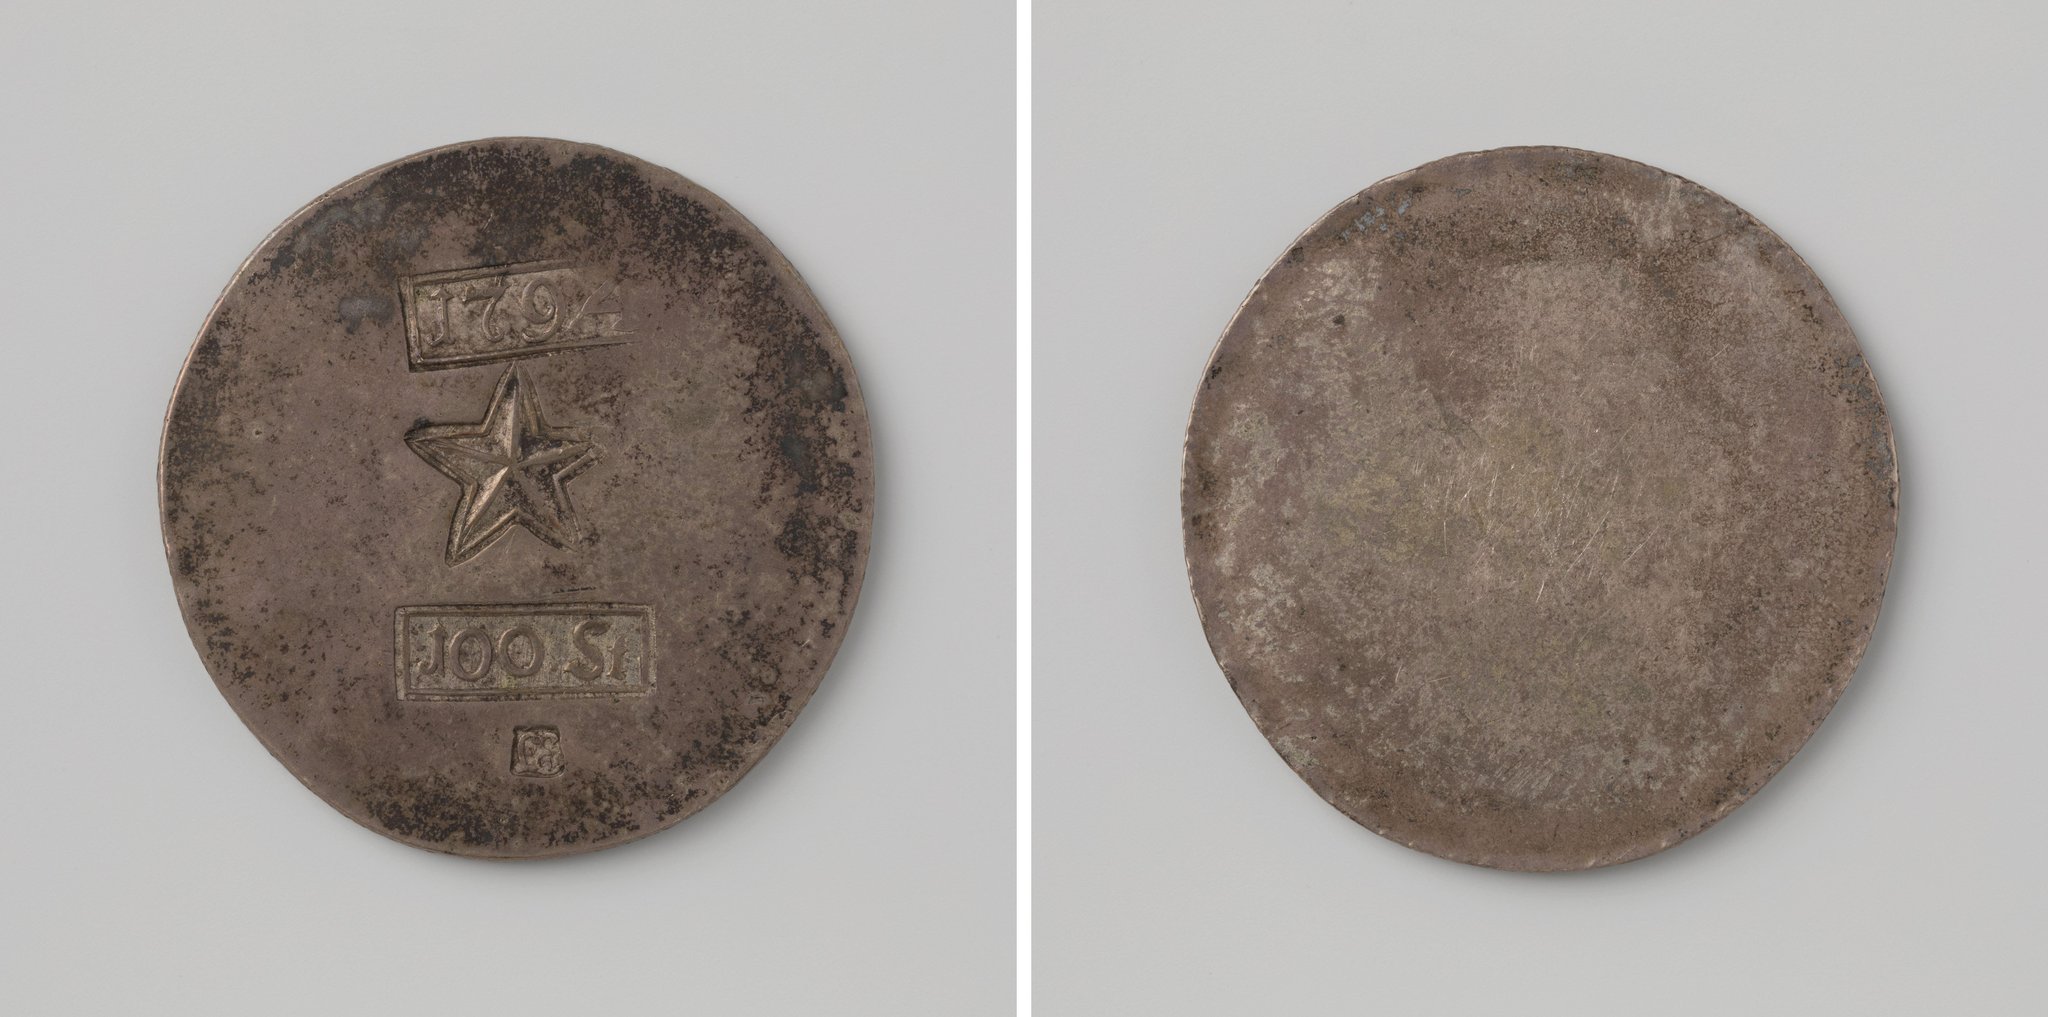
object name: honderd stuiver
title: Honderd stuiver, noodmunt van de stad Maastricht, 1794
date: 1794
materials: silver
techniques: striking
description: Zilveren noodmunt. Voorzijde: ster van Maastricht, daarboven in cartouche jaartal en daaronder in cartouche waarde-aanduiding. Onderaan klein monogram: LE. Keerzijde: glad.